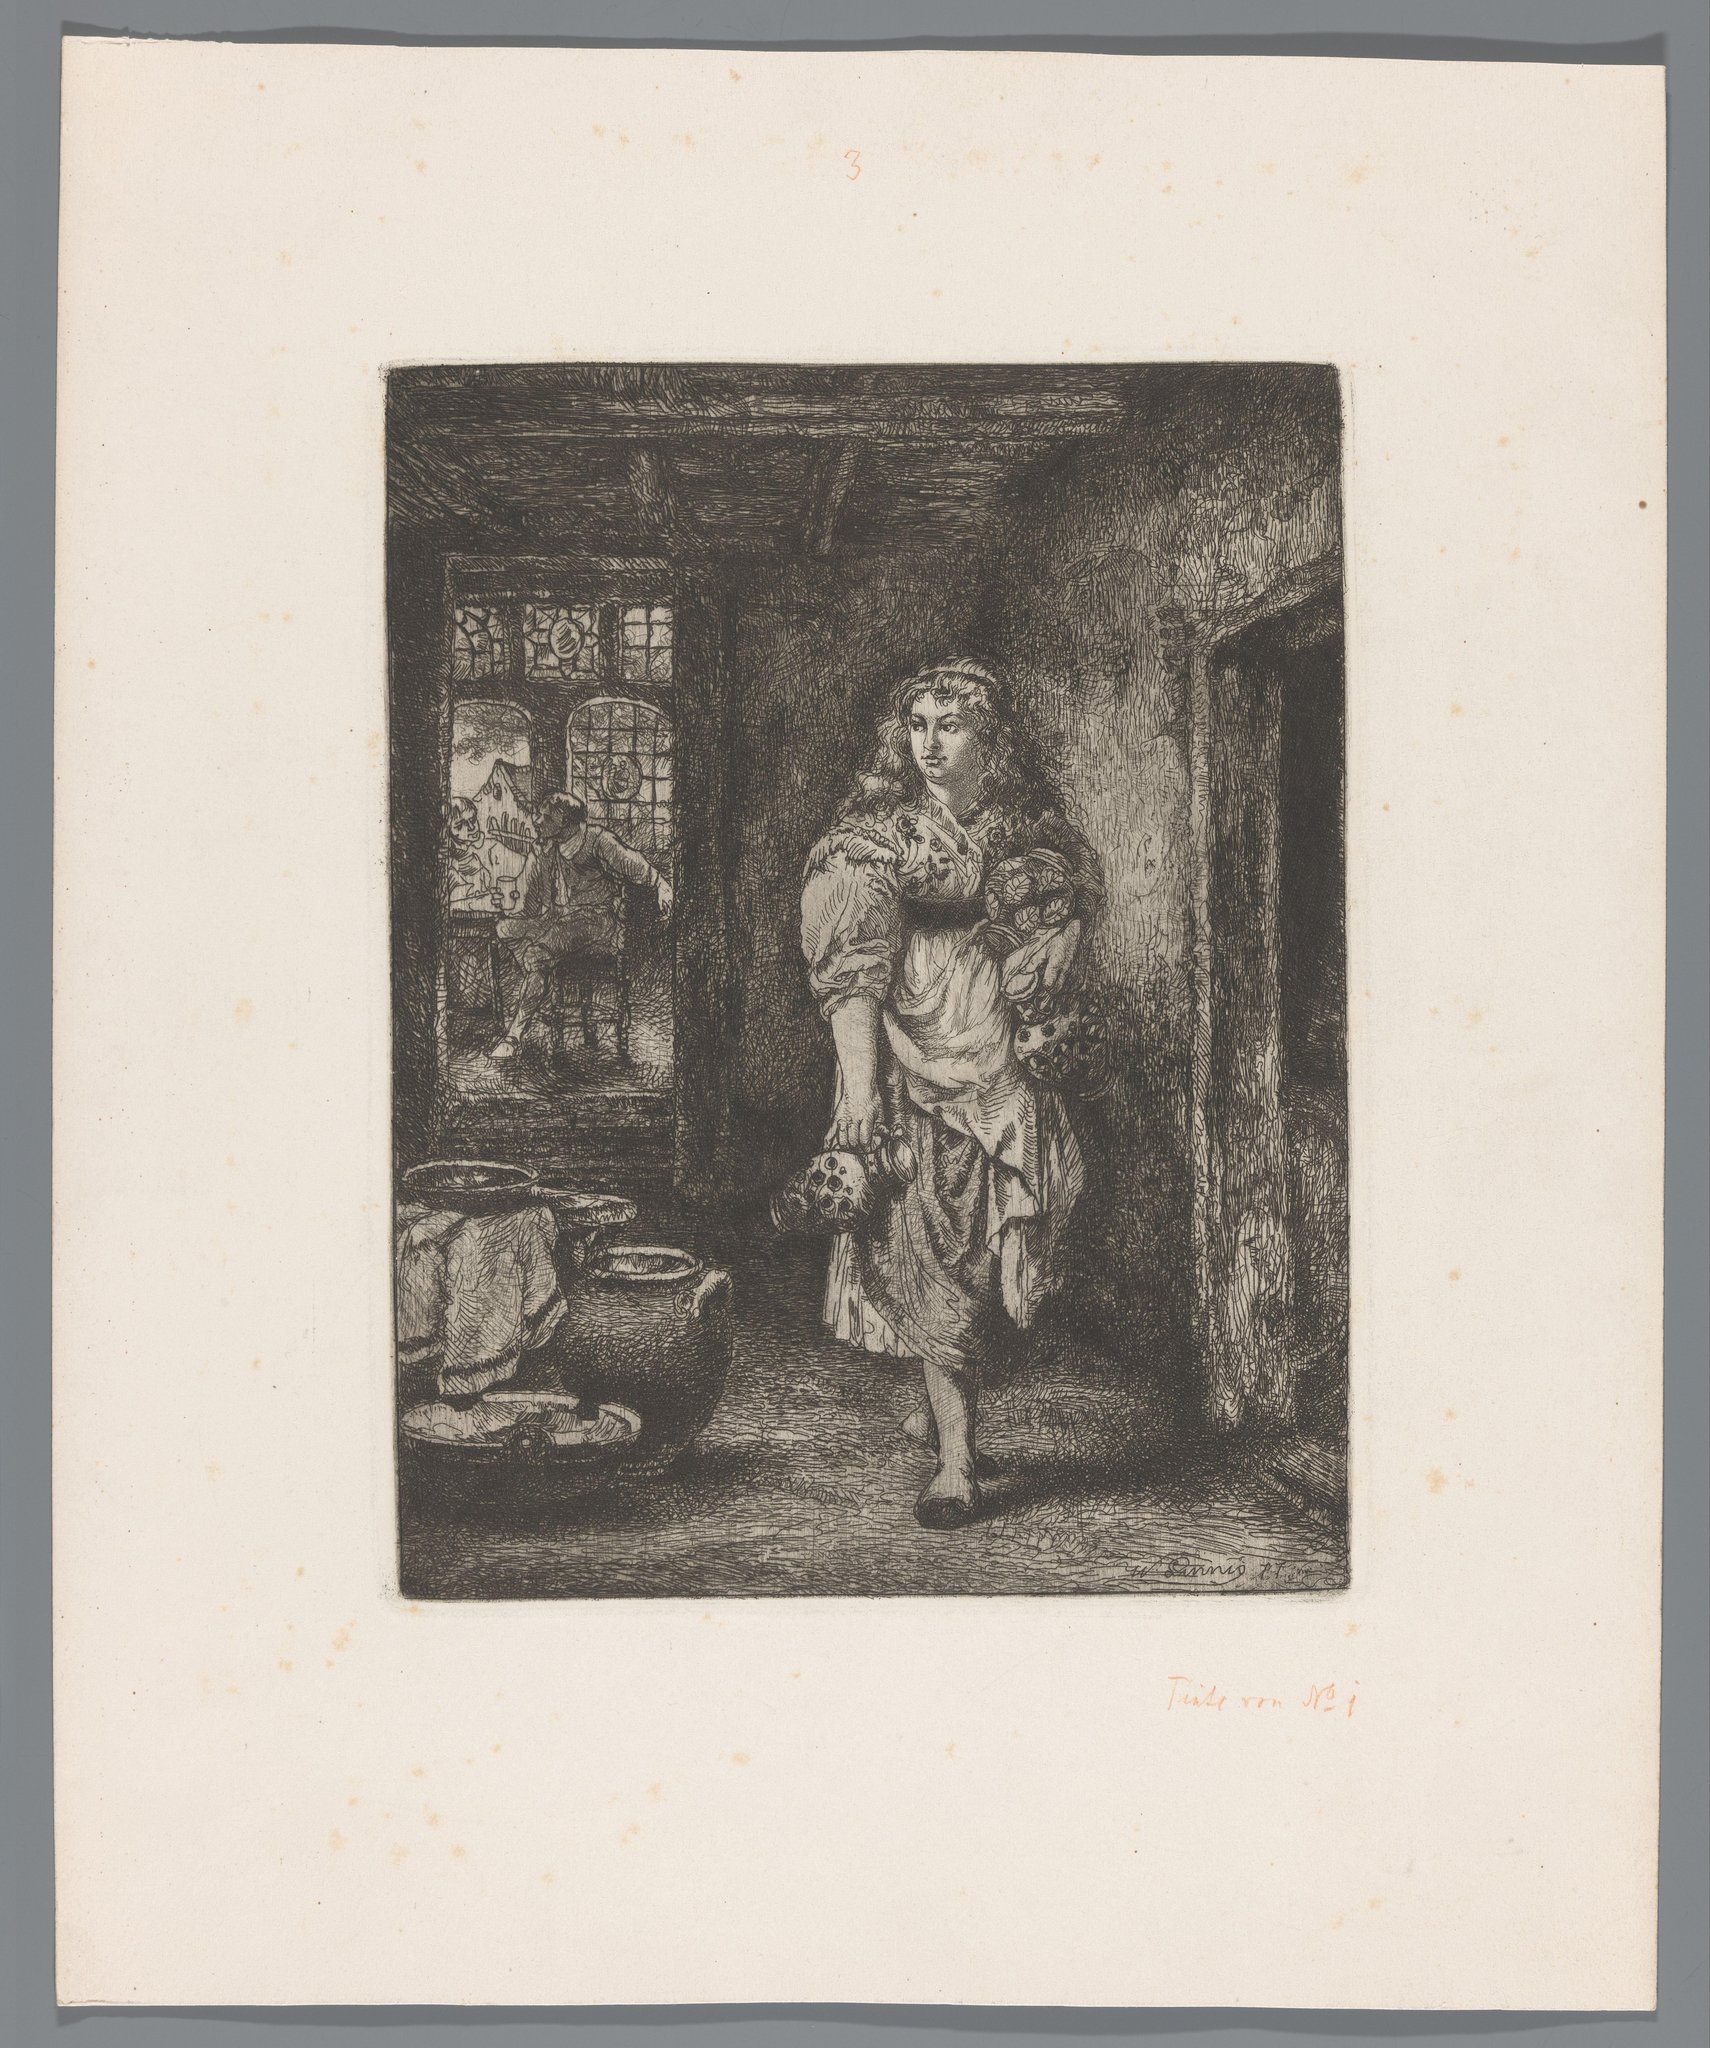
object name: print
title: Serveerster met kruiken in een herberg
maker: willem linnig (ii)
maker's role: print maker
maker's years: 1842-1890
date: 1877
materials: paper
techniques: drypoint, etching, intaglio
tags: inn, coffee-house, public house, etc. (+ waiter, waitress, etc.)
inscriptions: collector's mark: Lugt 2228